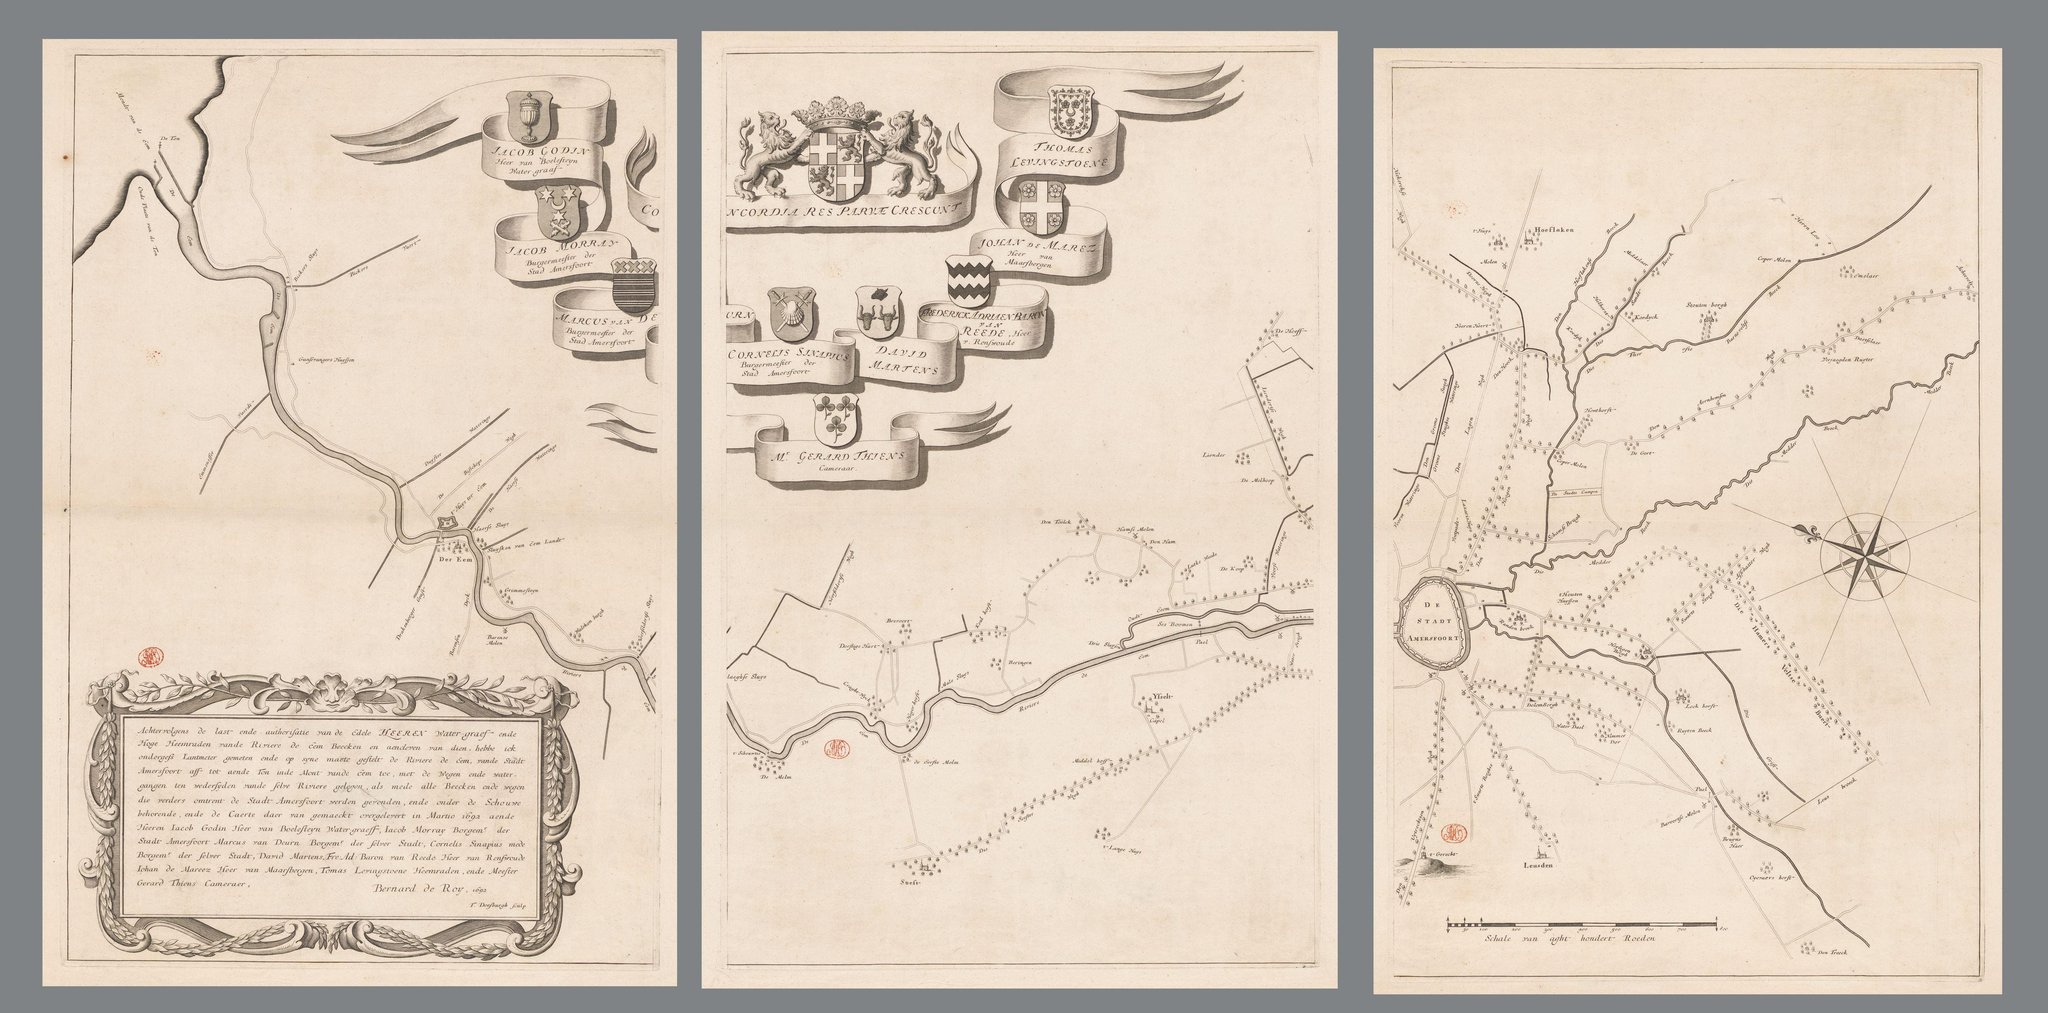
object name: map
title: Kaart van de rivier de Eem, bestaande uit drie delen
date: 1692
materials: paper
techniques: engraving, etching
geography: utrecht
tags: coat of arms (as symbol of the state, etc.), maps of separate countries or regions, river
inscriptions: collector's mark: Lugt 195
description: Dit object is omwille van een betere presentatie virtueel samengevoegd maar bestaat fysiek uit losse onderdelen. In tegenstelling tot latere beschreven staten komen de namen van de genoemde leden van het College van Watergraaf en Heemraden in de cartouche linksonder overeen met de afgebeelde namen en wapens op de kaart. Hiermee kan het huidige exemplaar gedateerd worden volgens de datering op de kaart: 1692, toen de genoemde personen lid waren van het College.